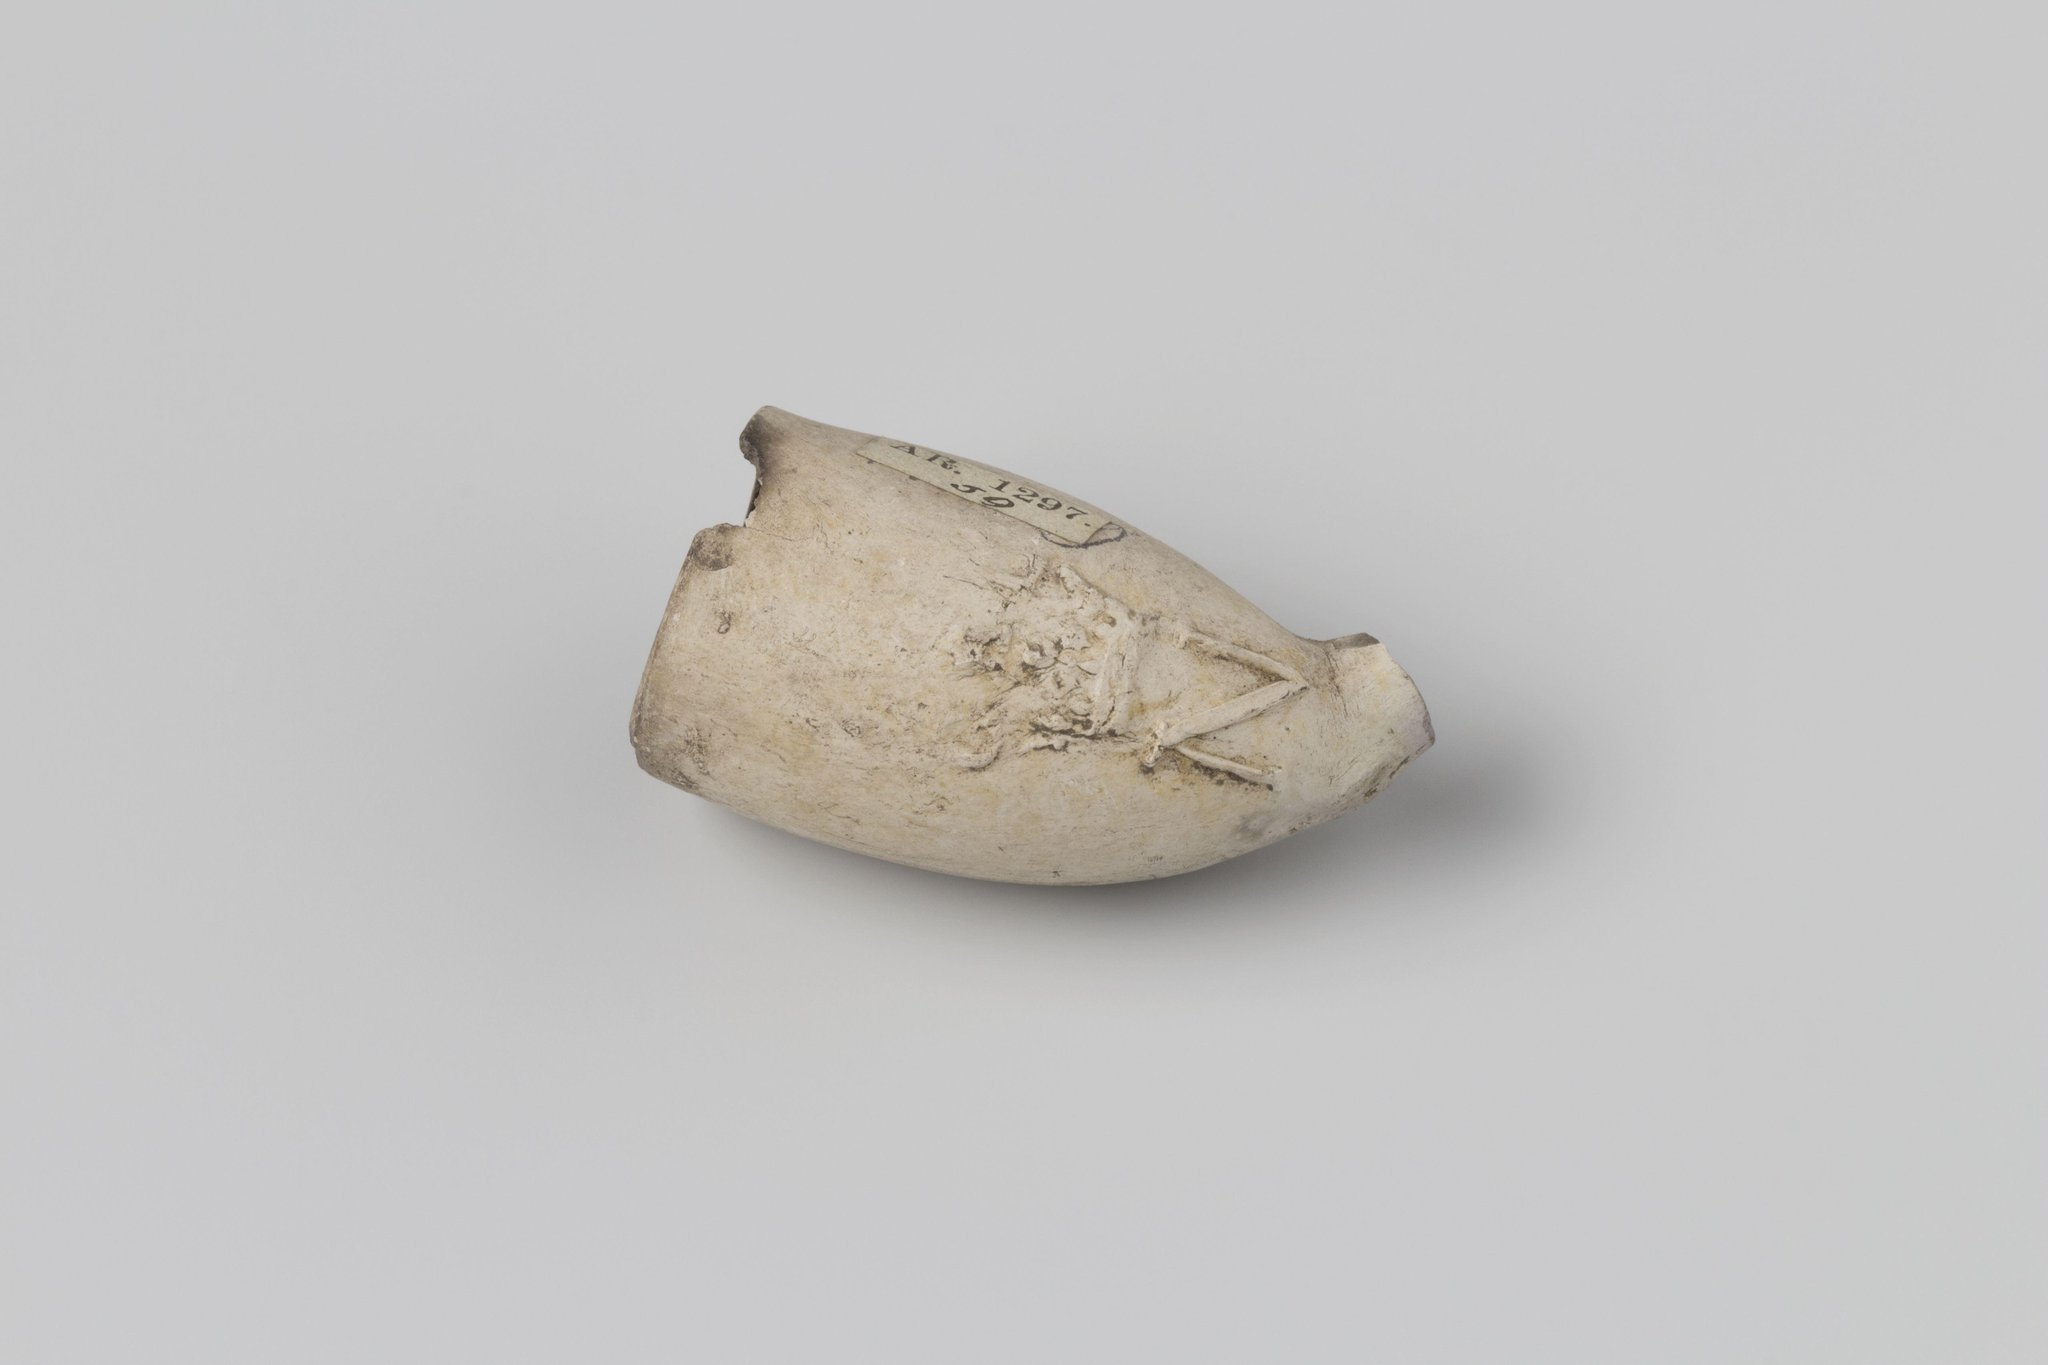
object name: pipe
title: Pijpenkop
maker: Anonymous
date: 1700-1799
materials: clay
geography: netherlands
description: Pijpenkop met een kroon en de letters G H L en N afgebeeld. Van de opgravingen op de Hofstede Arentsburg 1827-1831 onder toezicht van Professor Reuvens.